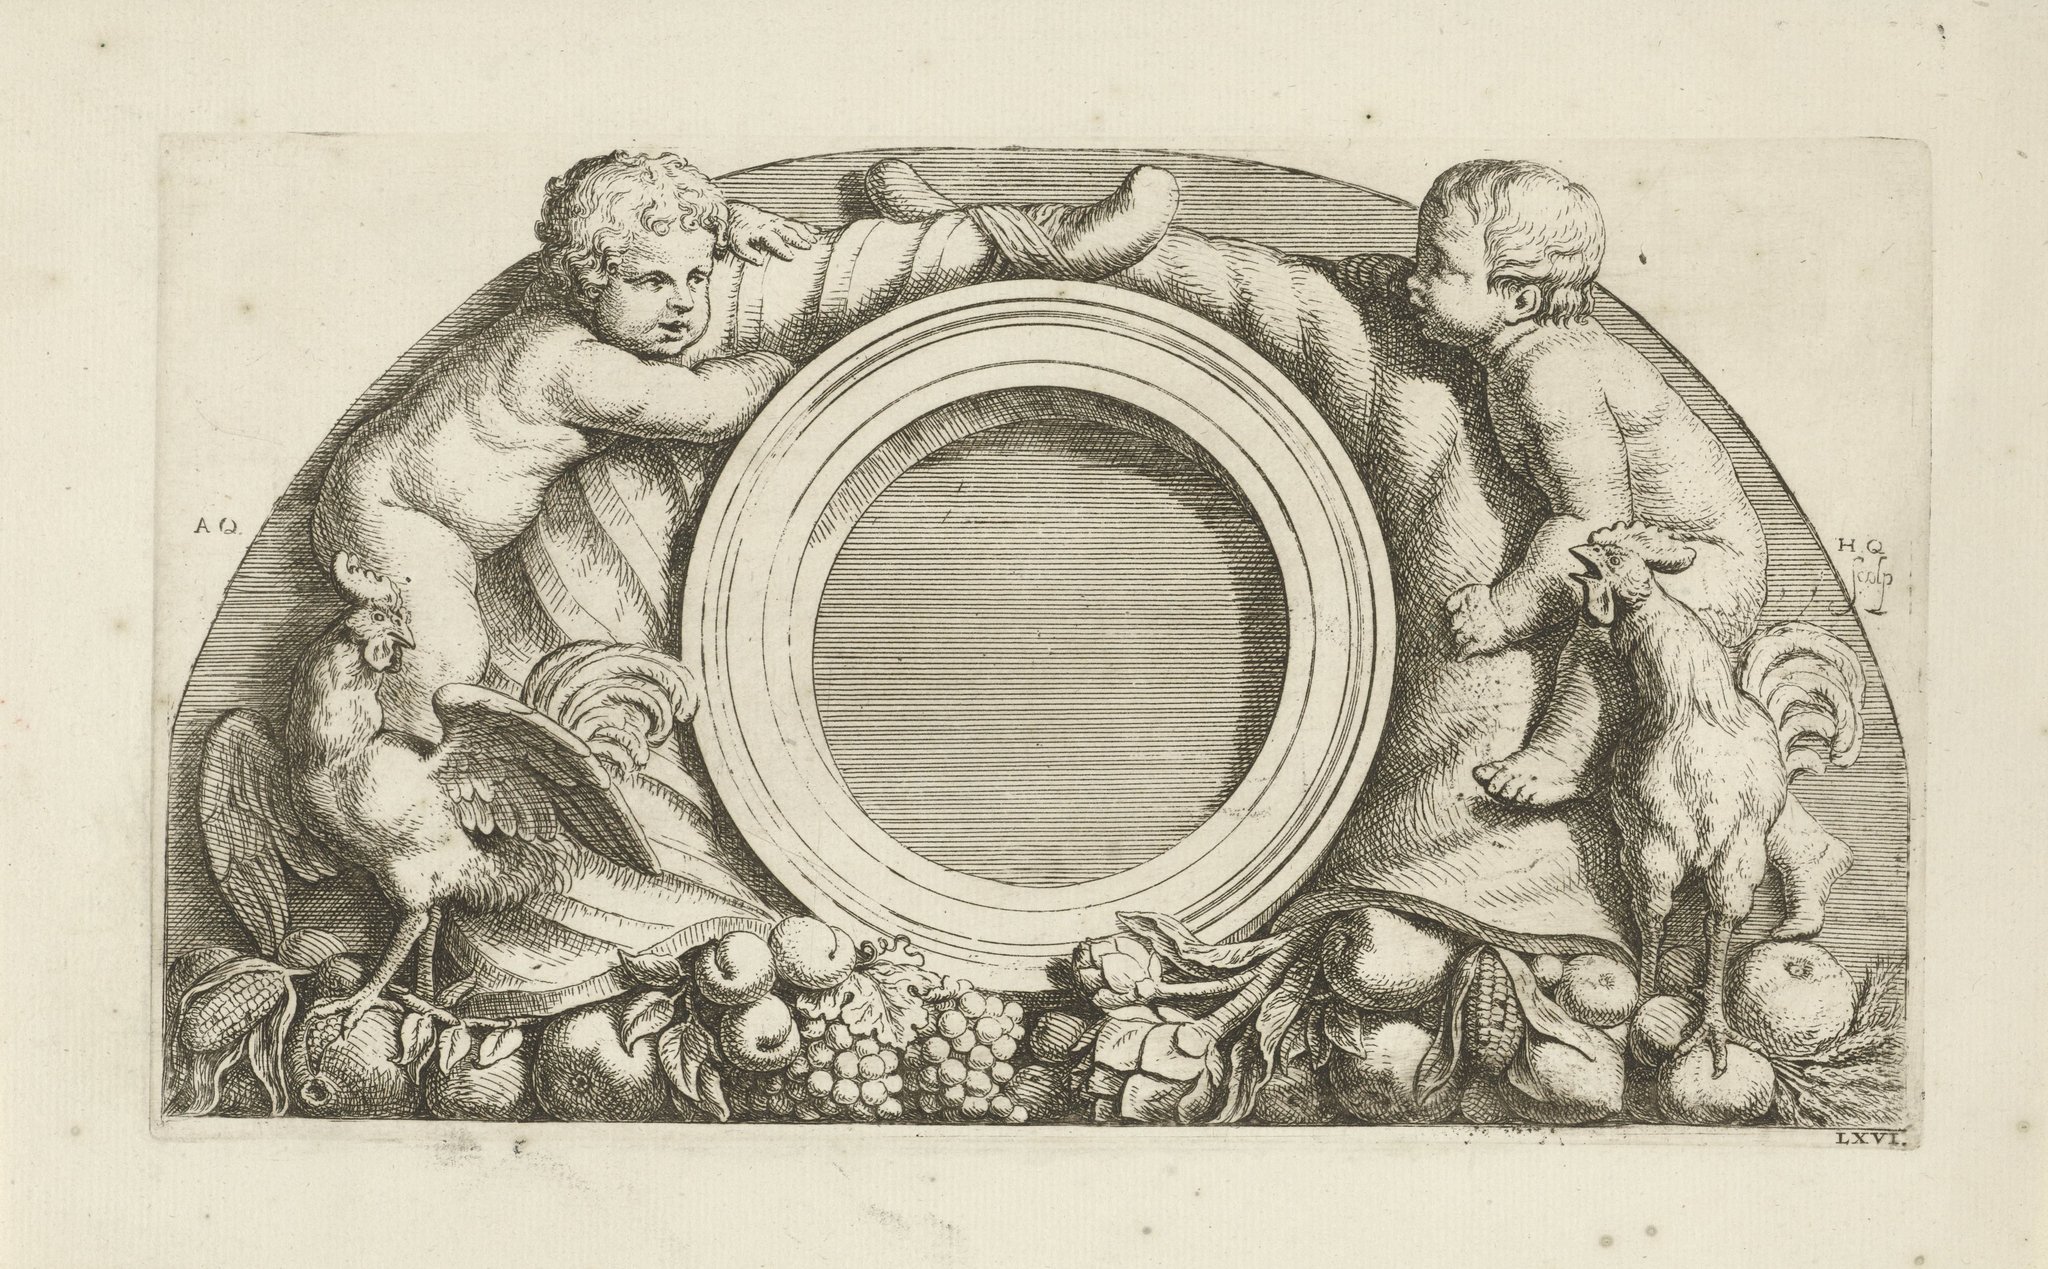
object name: print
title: Lunette met putti, hanen en hoornen des overvloeds in de westelijke galerij van het Stadhuis op de Dam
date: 1655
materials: paper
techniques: engraving, etching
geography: amsterdam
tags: 'cornucopia', horn of plenty, fowl (cock, hen, chicken, etc.), cupids: 'amores', 'amoretti', 'putti'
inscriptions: collector's mark: Lugt 2228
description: Huidige staat van prent ook gebruikt in: Architecture peinture et sculpture de la Maison de Ville d'Amsterdam, representee en CIX. figures en taille-douce (…). Amsterdam: David Mortier, 1719. En in: Architecture peinture et sculpture de la Maison de Ville d'Amsterdam, representee en CIX. figures en taille-douce (…). Amsterdam: Gerard Valck, 1719. En in: Bouw schilder en beeldhouwkonst, van het Stadhuis te Amsteldam, vertoont in CIX figuuren (…). Amsterdam: Covens & Mortier & Covens Jr., s.a. (1774-1783). Eerdere staat van prent ook gebruikt in: Prima pars. Praecipuarum effigierum ac ornamentorum, amplissimae Curiae Amstelrodamensis (…) / Het eerste deel. Van de voornaemste Statuen ende Ciraten, vant konstijck Stadhuys van Amstelredam, tmeeste in marmer gemaeckt, door Artus Quellinus, Beelthouwer der voorseyde Stadt / La Premier Partie. De plusieurs Figures et ornements, de la Maison de Ville d'Amsterdam (…). Amsterdam: Artus Quellinus (I), 1655. En in: Prima pars. Praecipuarum effigierum ac ornamentorum, amplissimae Curiae Amstelrodamensis (…) / Het eerste deel. Van de voornaemste Statuen ende Ciraten, vant konstijck Stadhuys van Amstelredam, tmeeste in marmer gemaeckt, door Artus Quellinus, Beelthouwer der voorseyde Stadt / La Premier Partie. De plusieurs Figures et ornements, de la Maison de Ville d'Amsterdam (…). Amsterdam: Frederik de Wit, 1665.